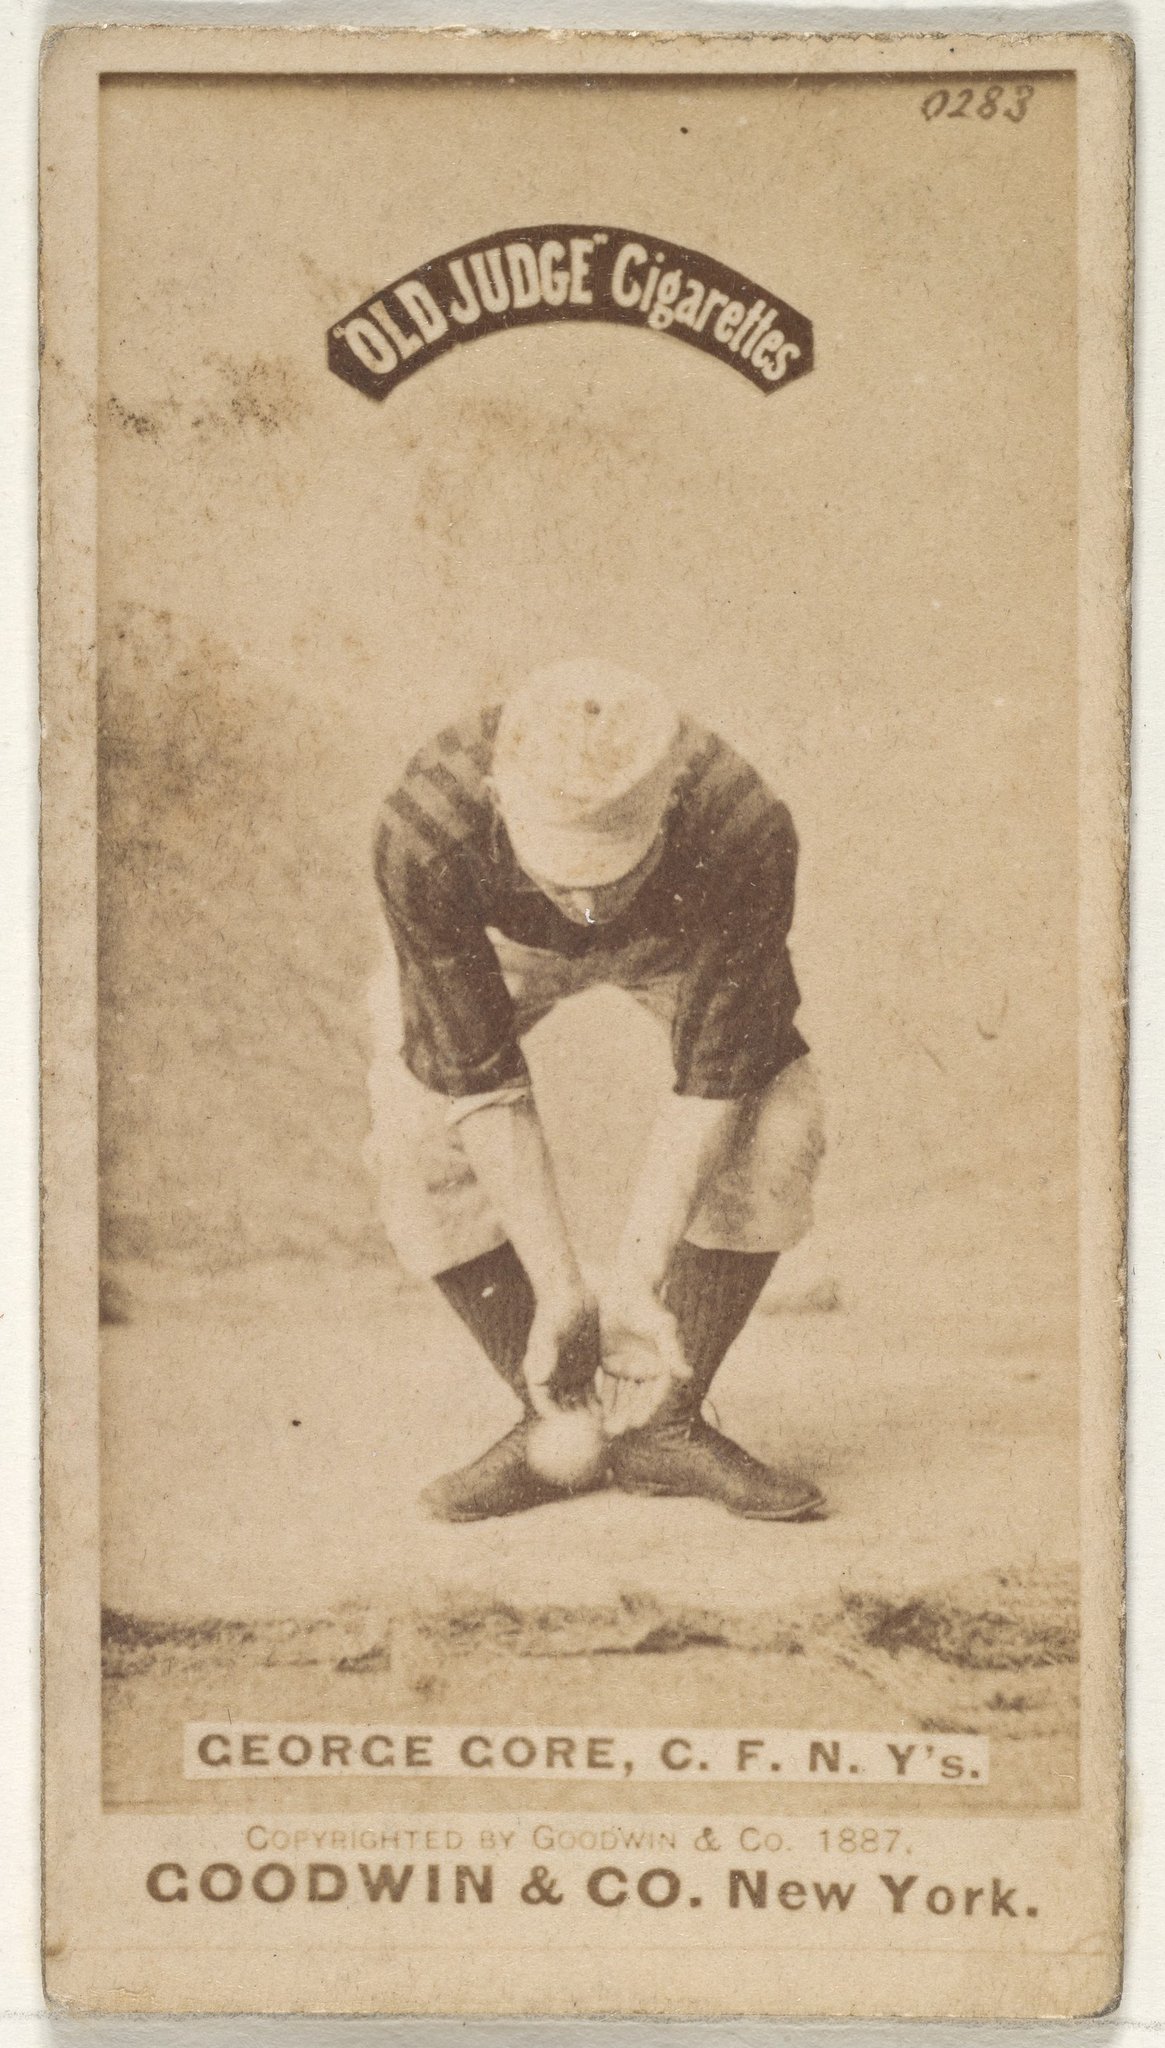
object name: baseball card, photograph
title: George F. "Piano Legs" Gore, Center Field, New York, from the Old Judge series (N172) for Old Judge Cigarettes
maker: goodwin & company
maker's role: publisher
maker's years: 1850-1950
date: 1887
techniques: albumen silver print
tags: men,portraits,baseball,athletes